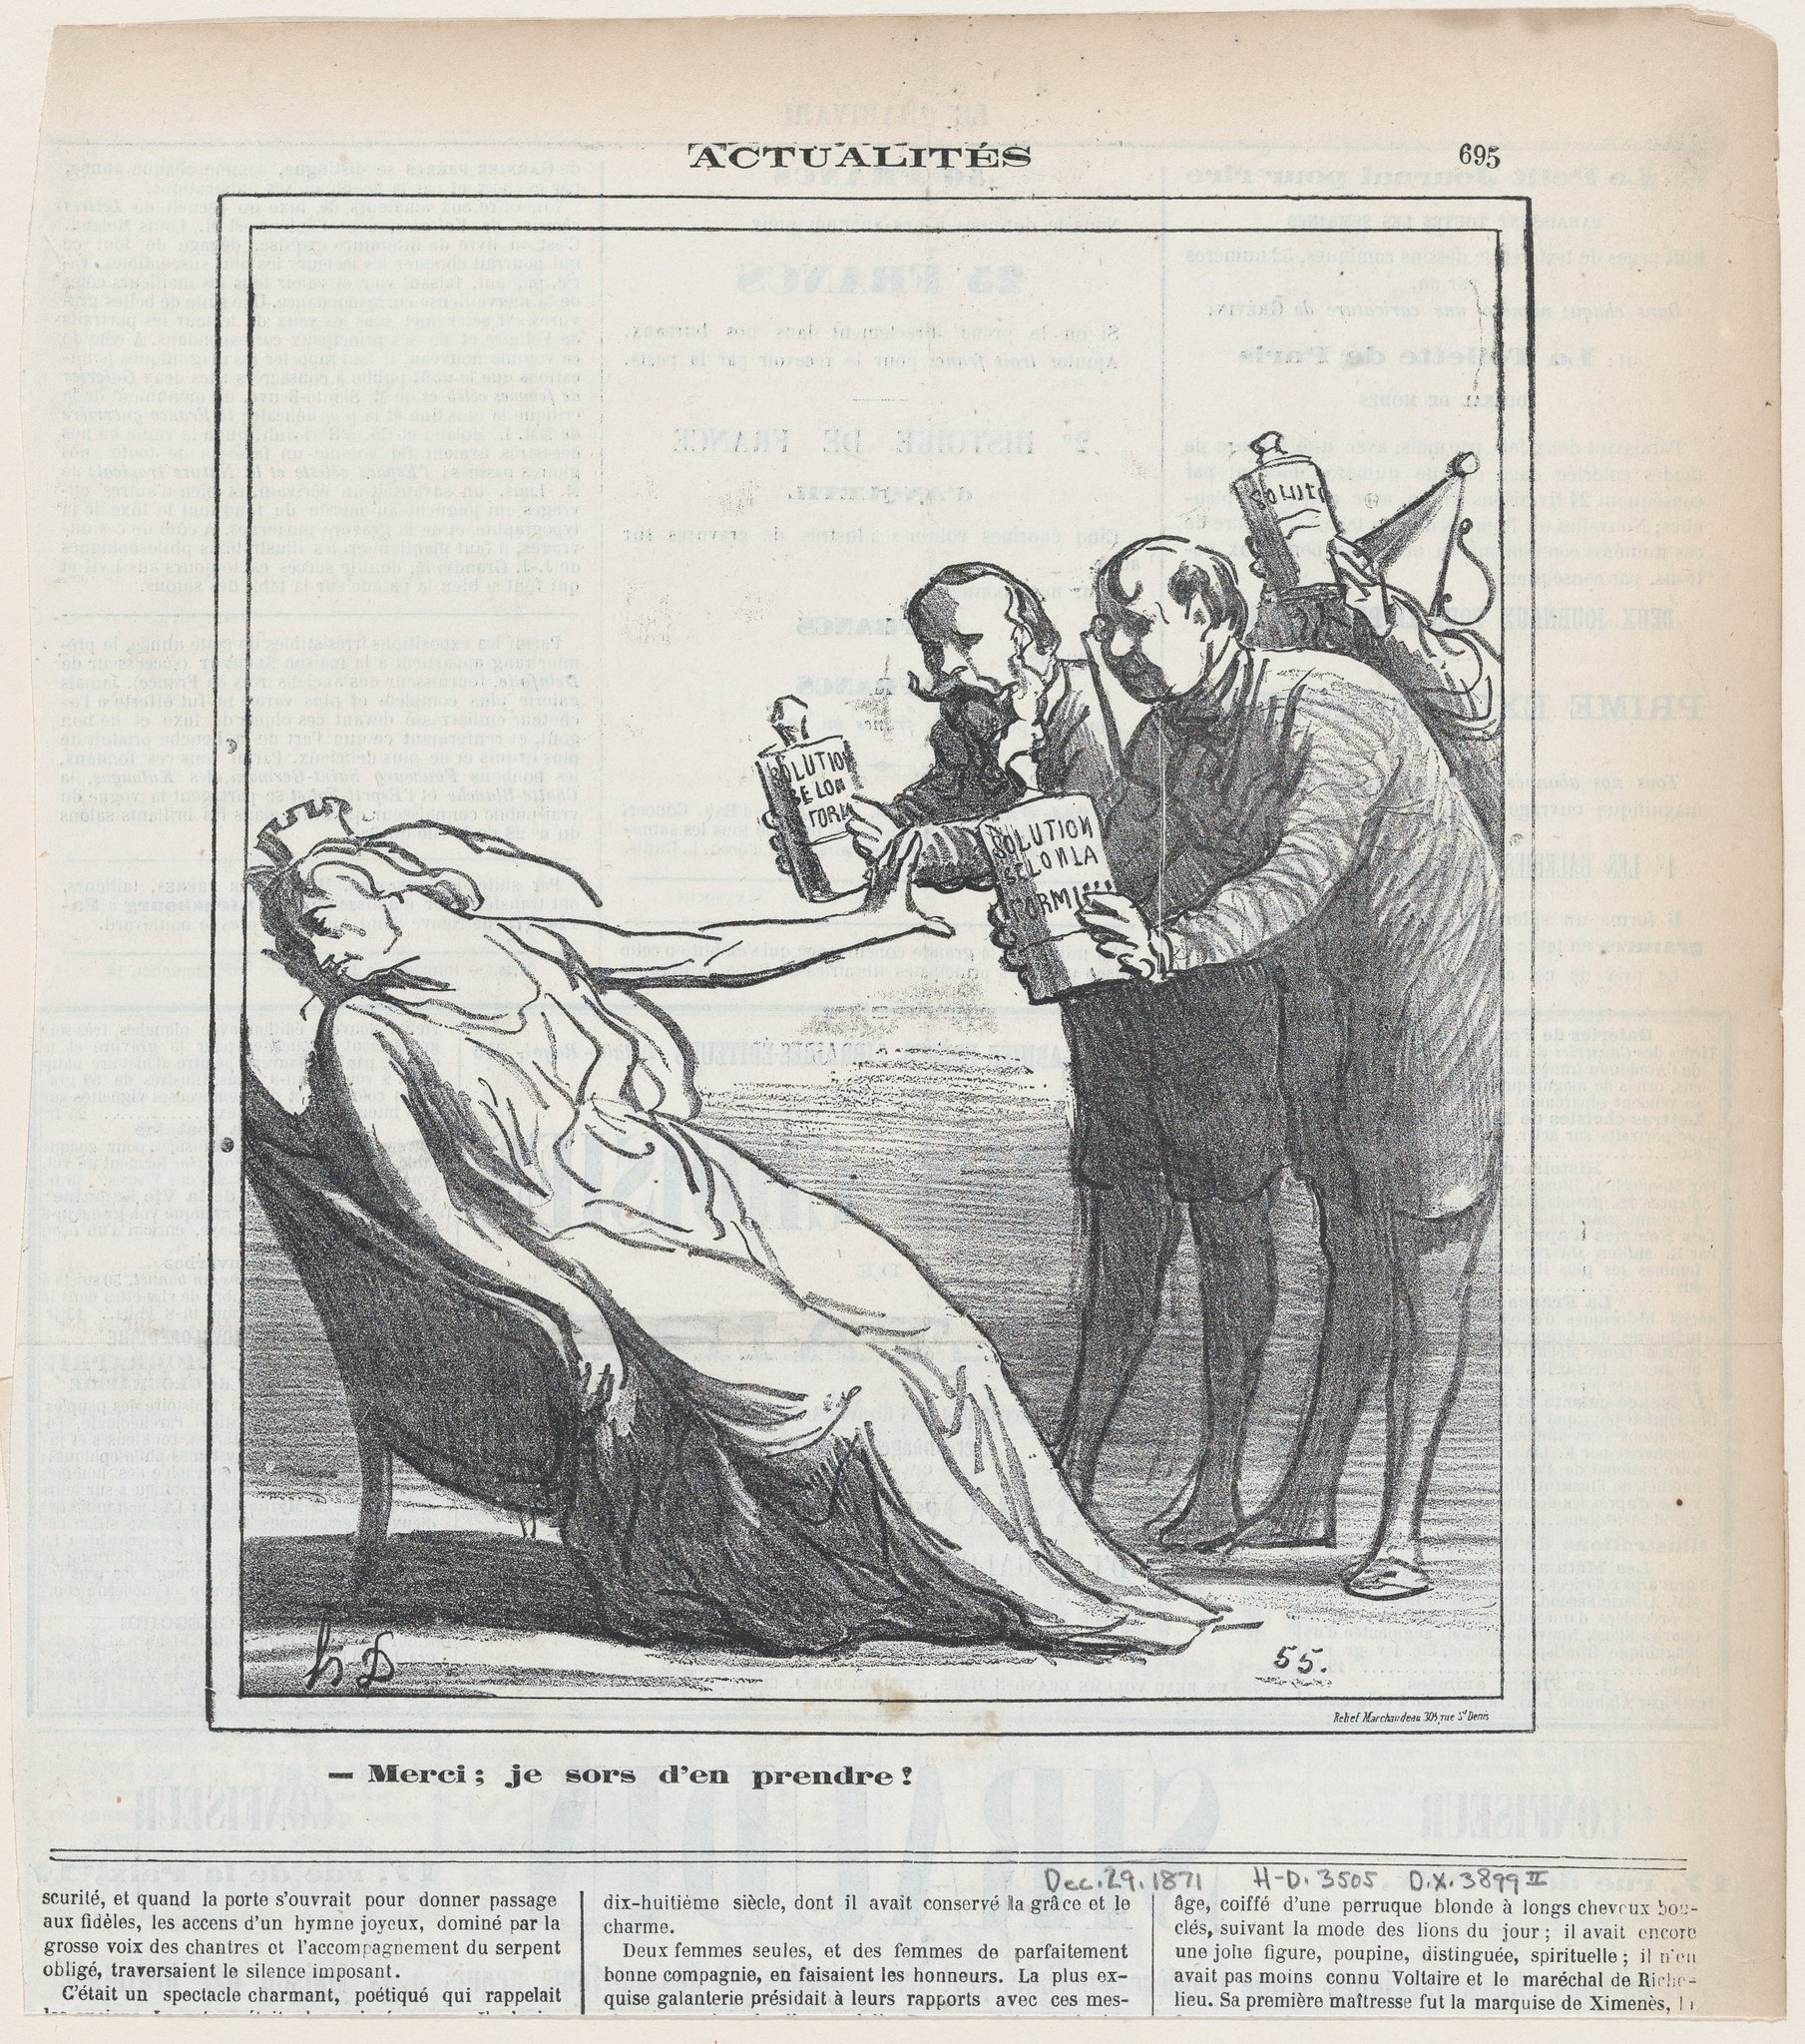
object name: print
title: Thanks, I can do quite well without!, from 'News of the day,' published in Le Charivari, December 29, 1871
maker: honoré daumier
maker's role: artist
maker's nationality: french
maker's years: 1808-1879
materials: paper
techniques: lithograph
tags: satire,men,women